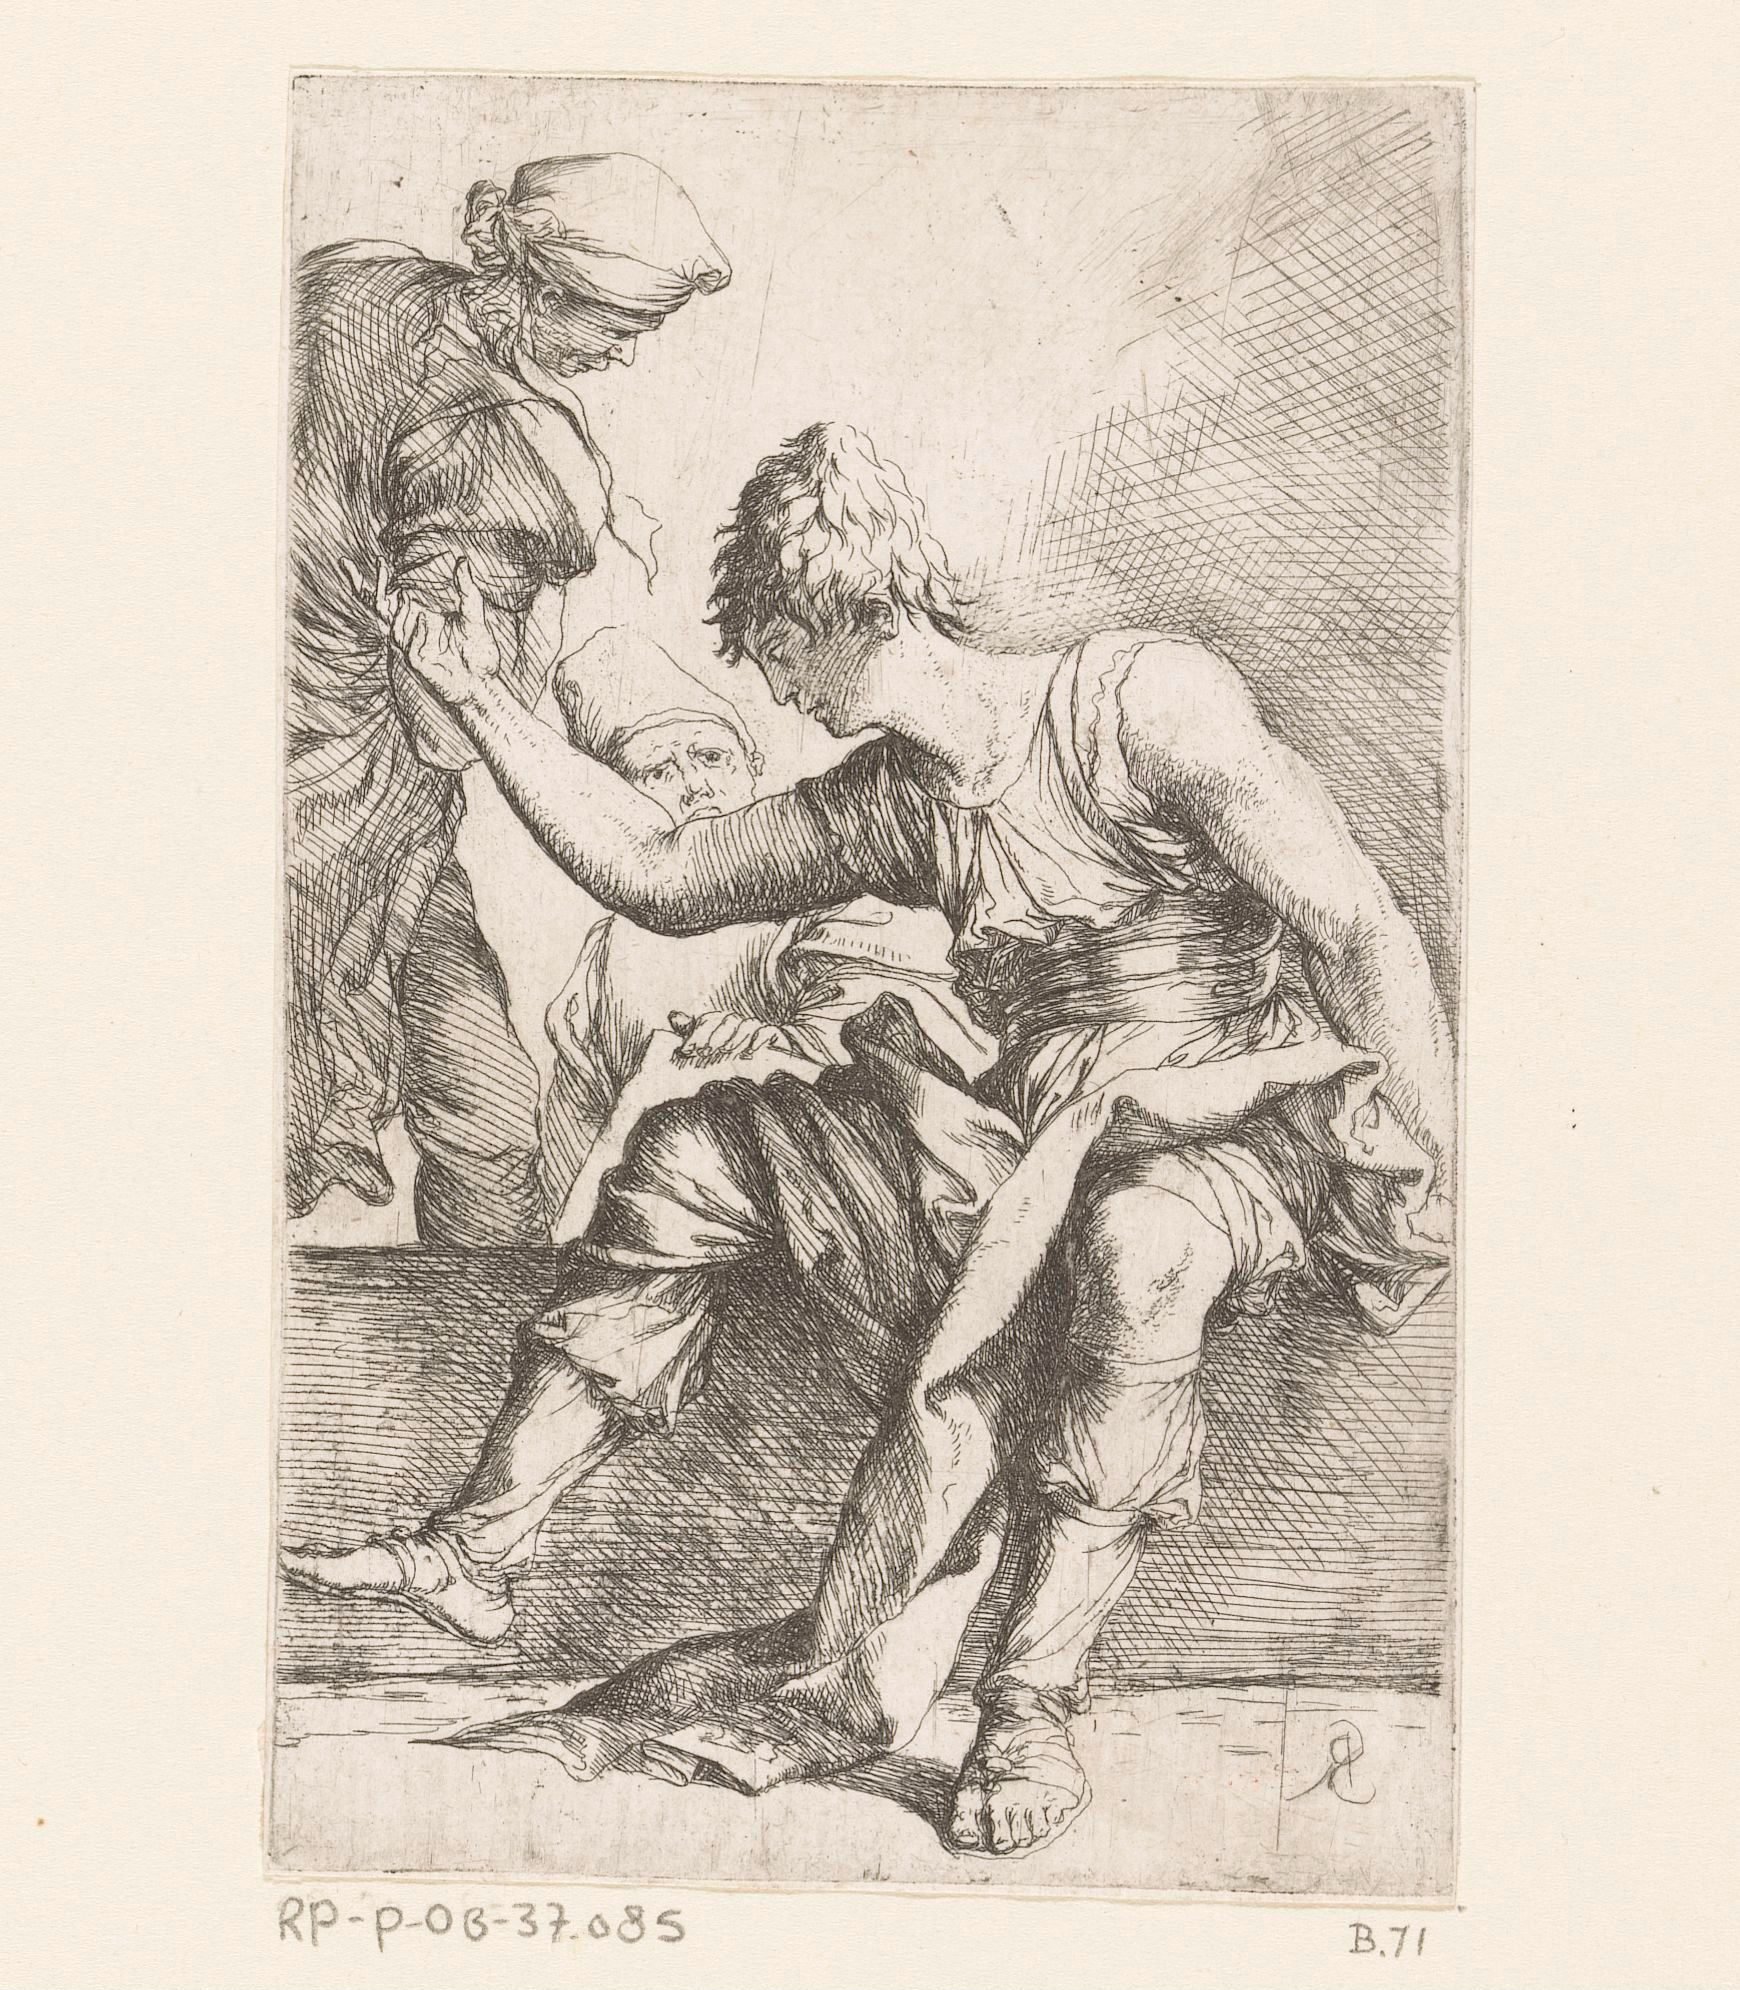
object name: print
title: Kleine figuren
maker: salvator rosa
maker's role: draughtsman, painter, print maker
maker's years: 1615-1673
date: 1656-1657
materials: paper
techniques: drypoint, etching, intaglio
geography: italy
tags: head-gear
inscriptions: collector's mark: Lugt 240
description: Prent spiegelbeeldig naar een tekening in de National Gallery of Art te Washington D.C. (voorheen in de collectie Ladislao Odescalchi te Rome). Deze prent maakt deel uit van de serie 'Figurine', bestaande uit een titelprent en 80 prenten van klein formaat met voorstellingen van mannelijke en vrouwelijke figuren. Rosa produceerde de serie waarschijnlijk gedurende de jaren 1656 en 1657.